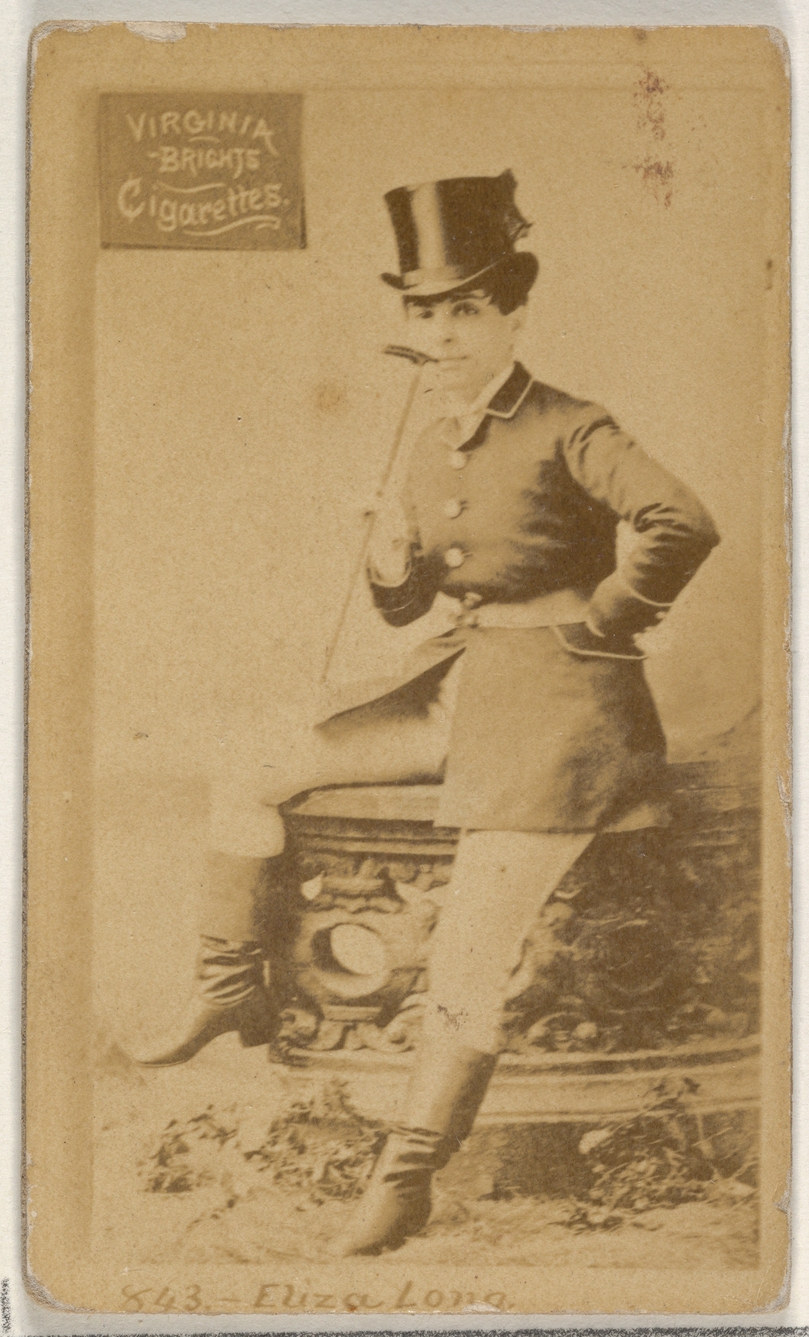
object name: photograph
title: Card 843, Eliza Long, from the Actors and Actresses series (N45, Type 2) for Virginia Brights Cigarettes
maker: allen & ginter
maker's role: publisher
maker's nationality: american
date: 1888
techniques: albumen silver print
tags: portraits,women,actresses